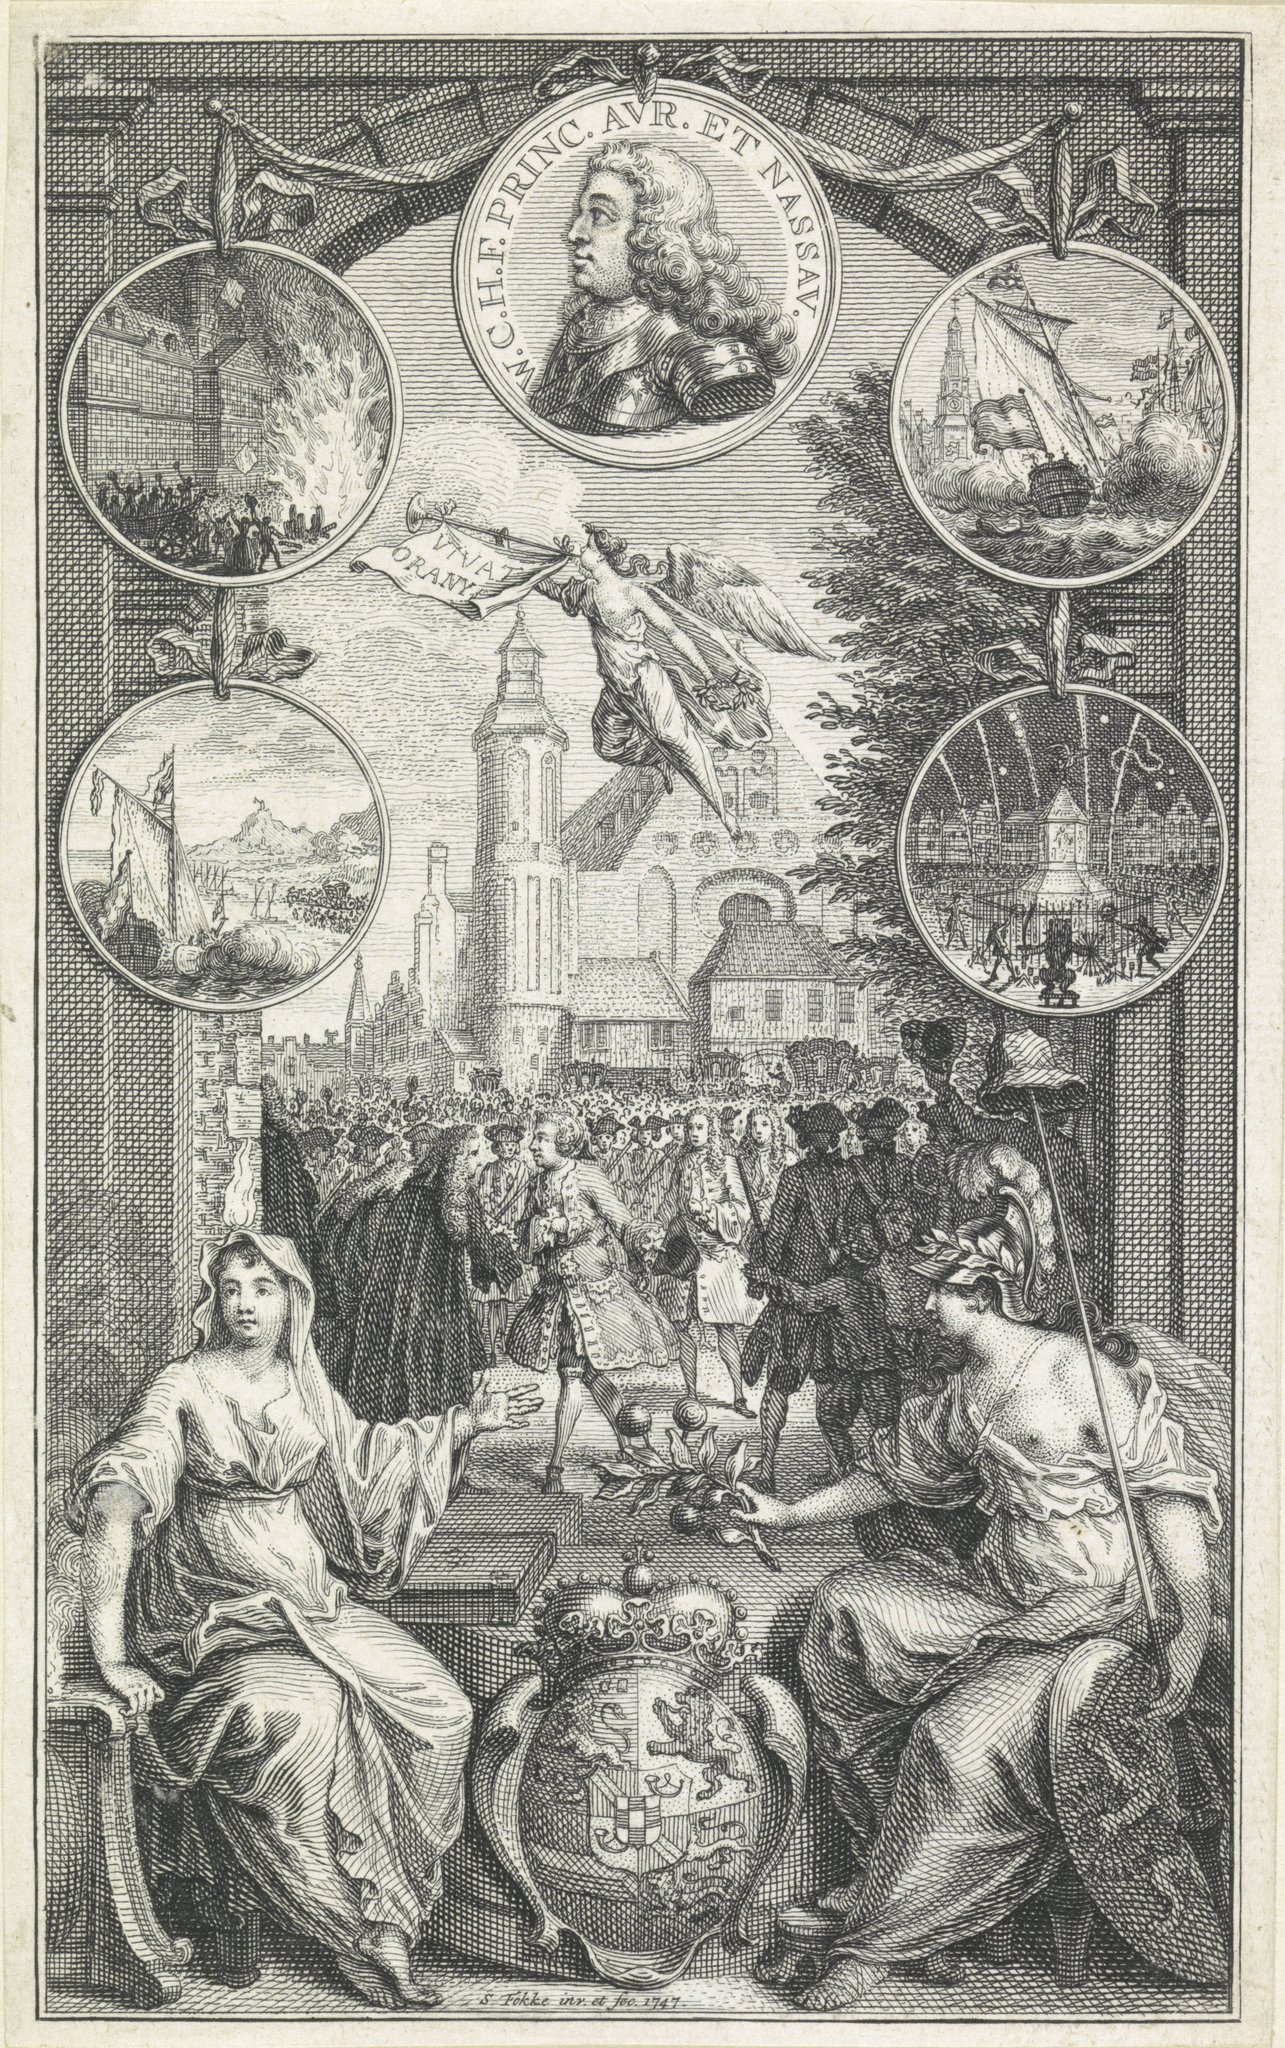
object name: print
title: Portret van Willem IV, prins van Oranje-Nassau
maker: simon fokke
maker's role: draughtsman, print maker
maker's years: 1712-1784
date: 1747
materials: paper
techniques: engraving, etching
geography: amsterdam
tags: the hague, willem iv (prins van oranje-nassau), fame; 'fama', 'fama buona', 'fama chiara' (ripa) (+ abstract concept represented by female figure)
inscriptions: collector's mark: Lugt 2228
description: Portret van Willem IV in een cirkel met randschrift. Links en rechts vier cirkels met voorstellingen van feestvreugde op verschillende plaatsen in het land. Daaronder de aankomst van Willem IV te Den Haag, 29 april 1747, en de verheffing van Willem IV tot erfstadhouder, 1747. In de lucht blaast Faam op haar bazuin. Op de voorgrond zijn wapen met een kroon, de Vrijheid en de Nederlandse Maagd.